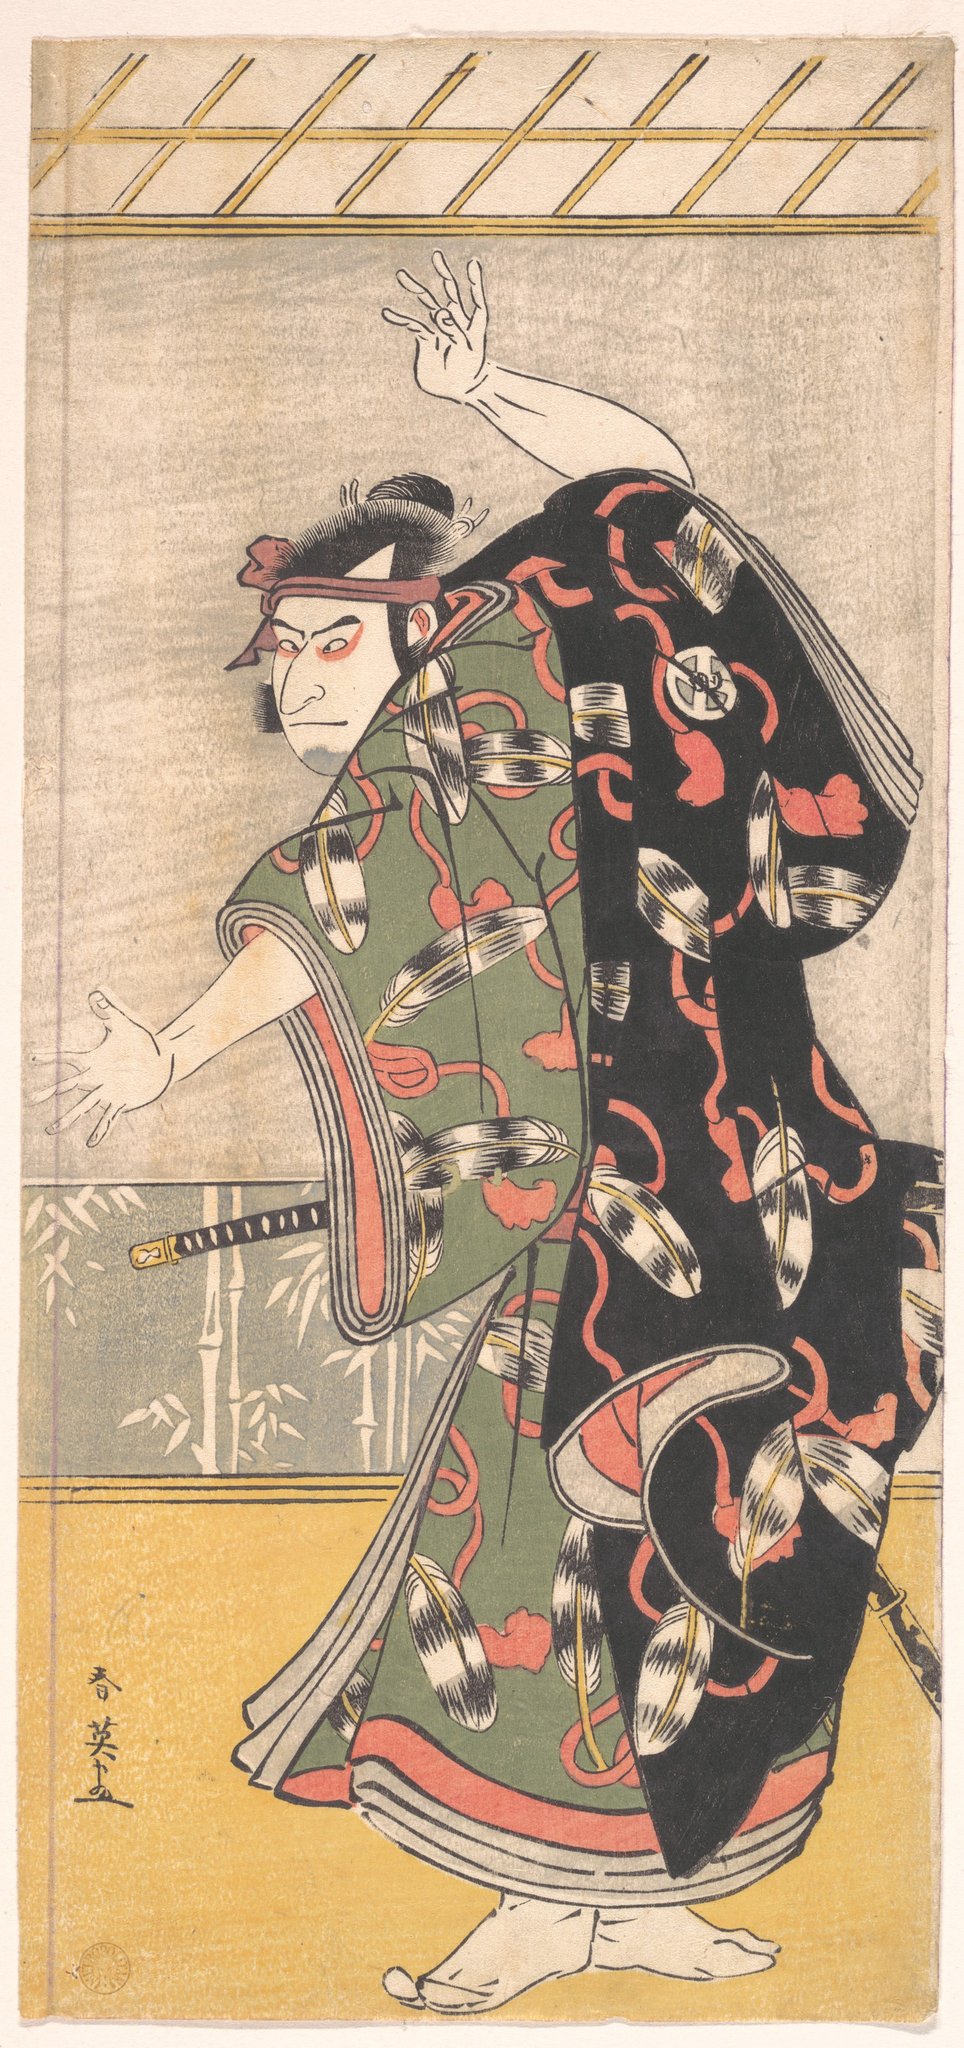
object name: woodblock print nishiki e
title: Kabuki Actor Ōtani Oniji III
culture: japanese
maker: katsukawa shun'ei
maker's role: artist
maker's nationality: japanese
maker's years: 1762-1819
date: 1792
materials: ink, paper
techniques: nishiki e, woodblock print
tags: samurai,men,actors